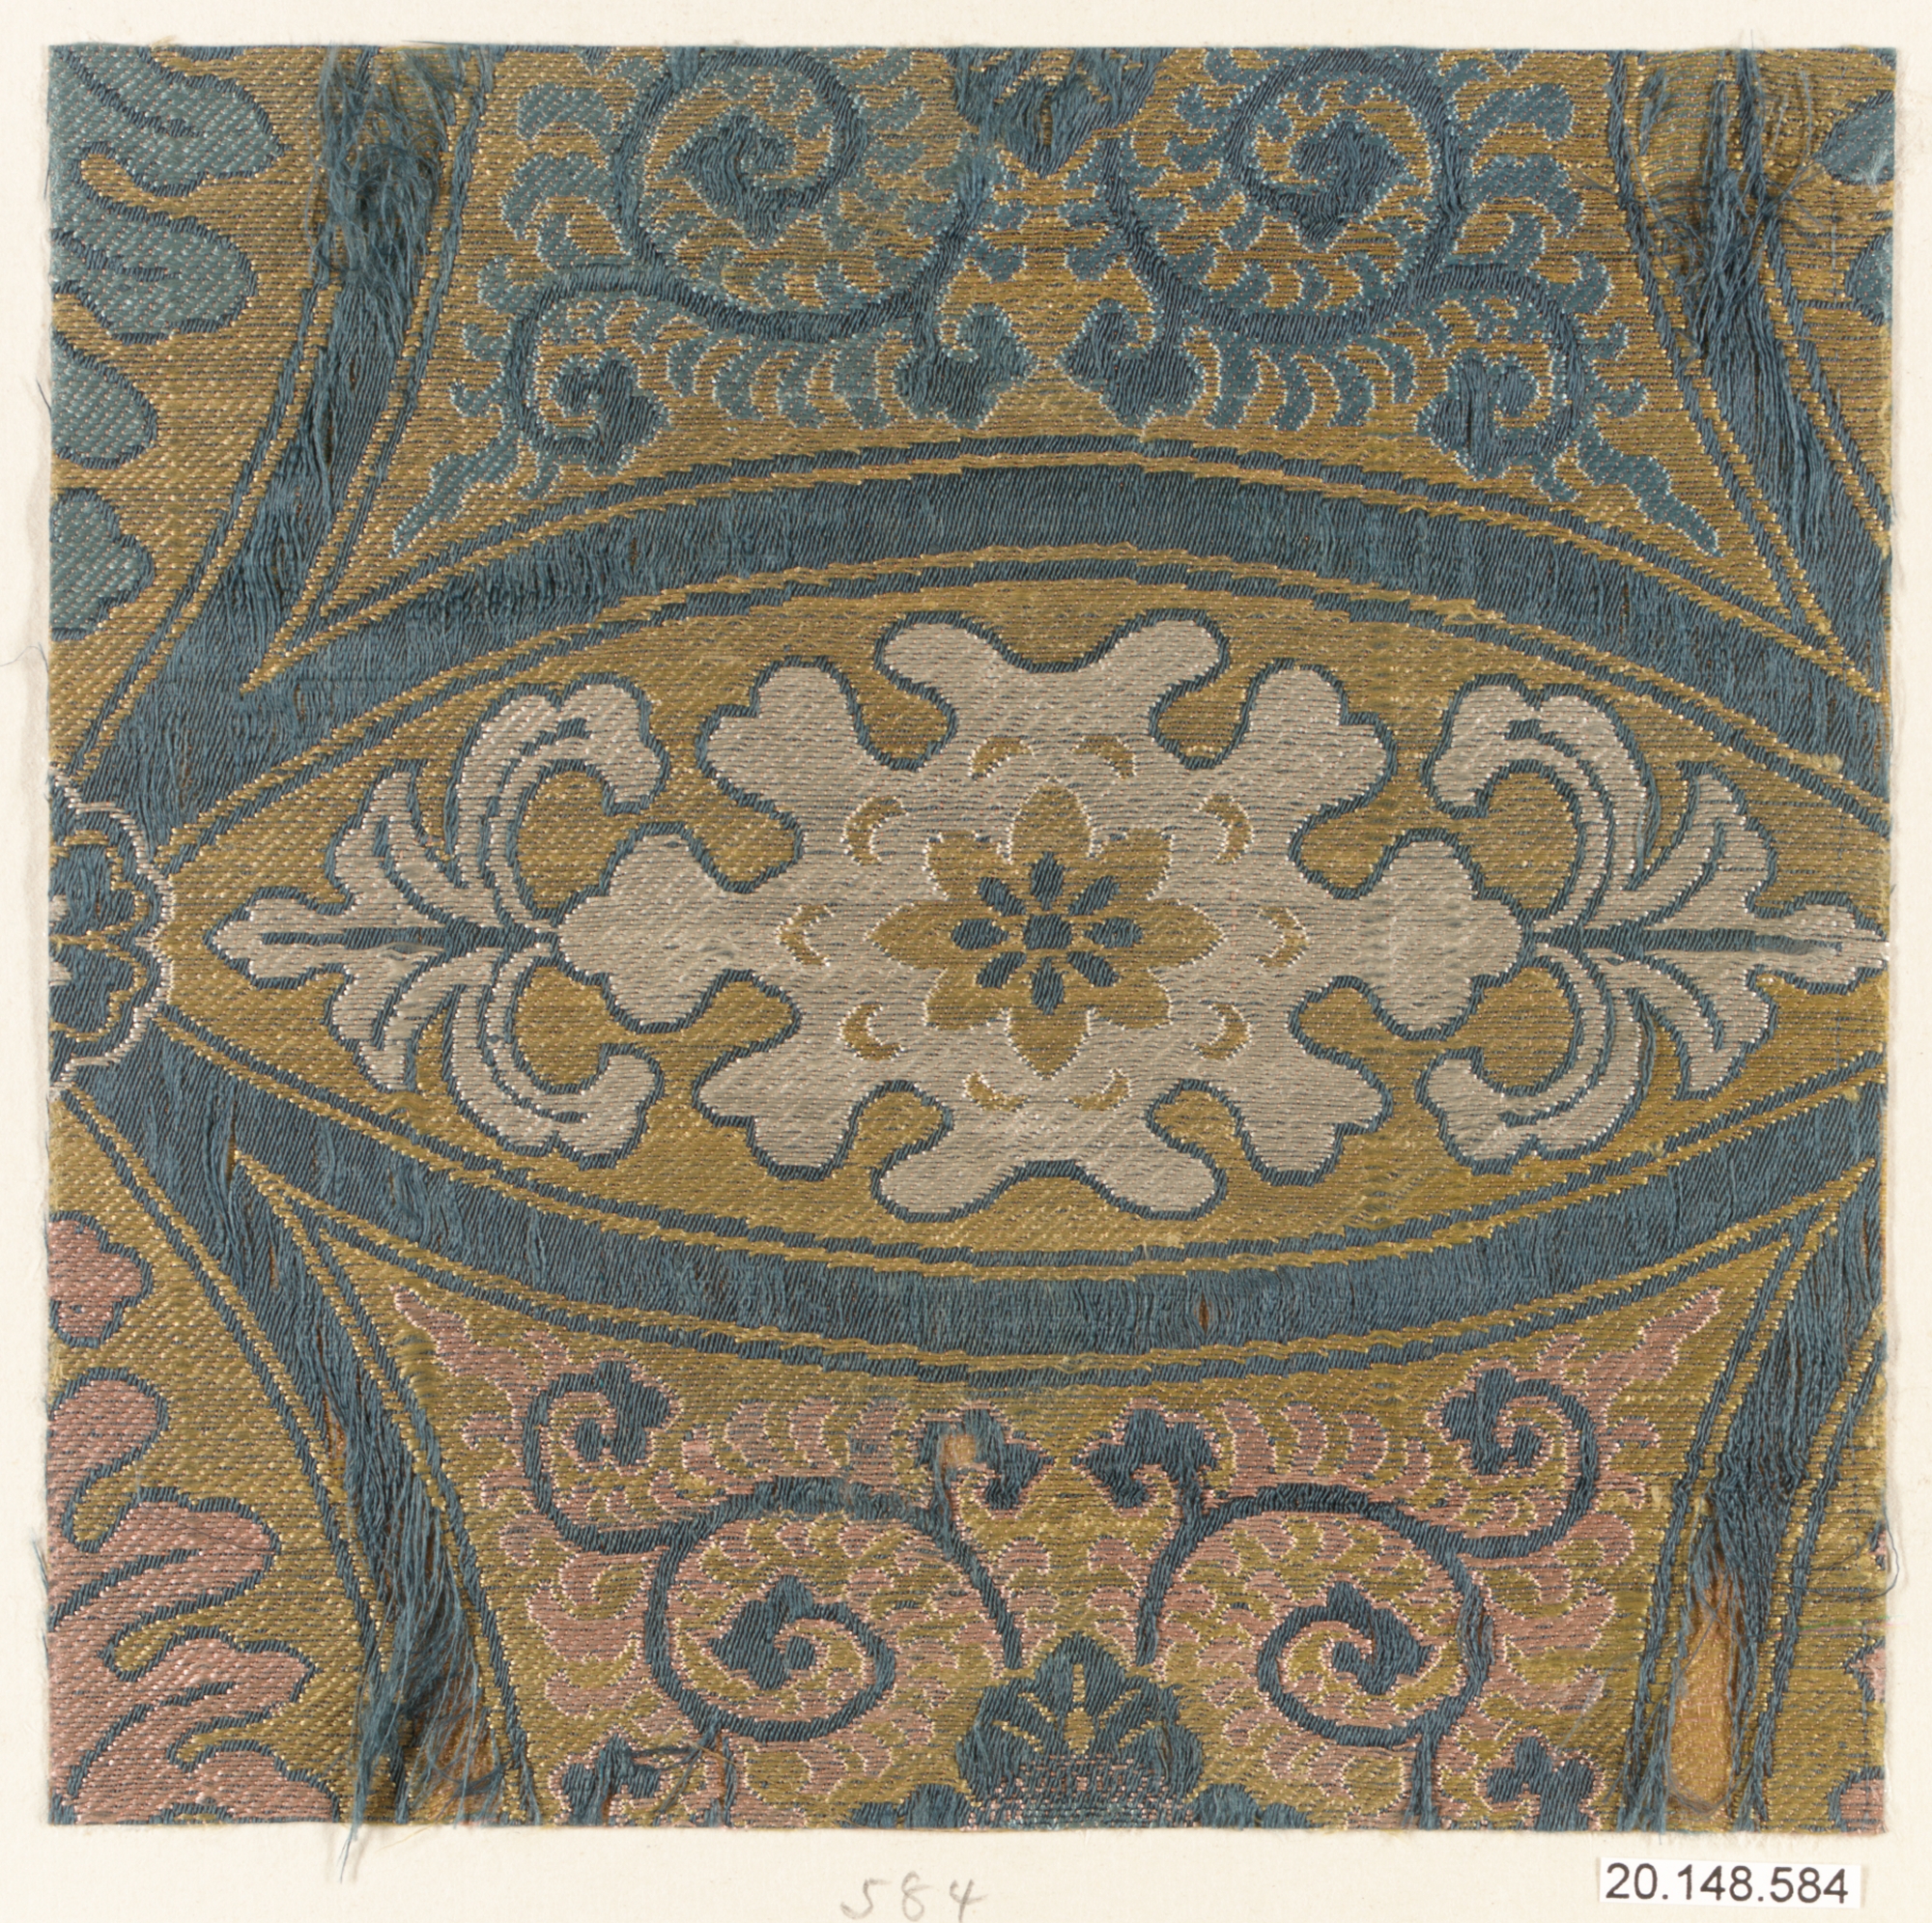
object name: piece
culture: japanese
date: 1701-1800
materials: silk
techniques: compound weave